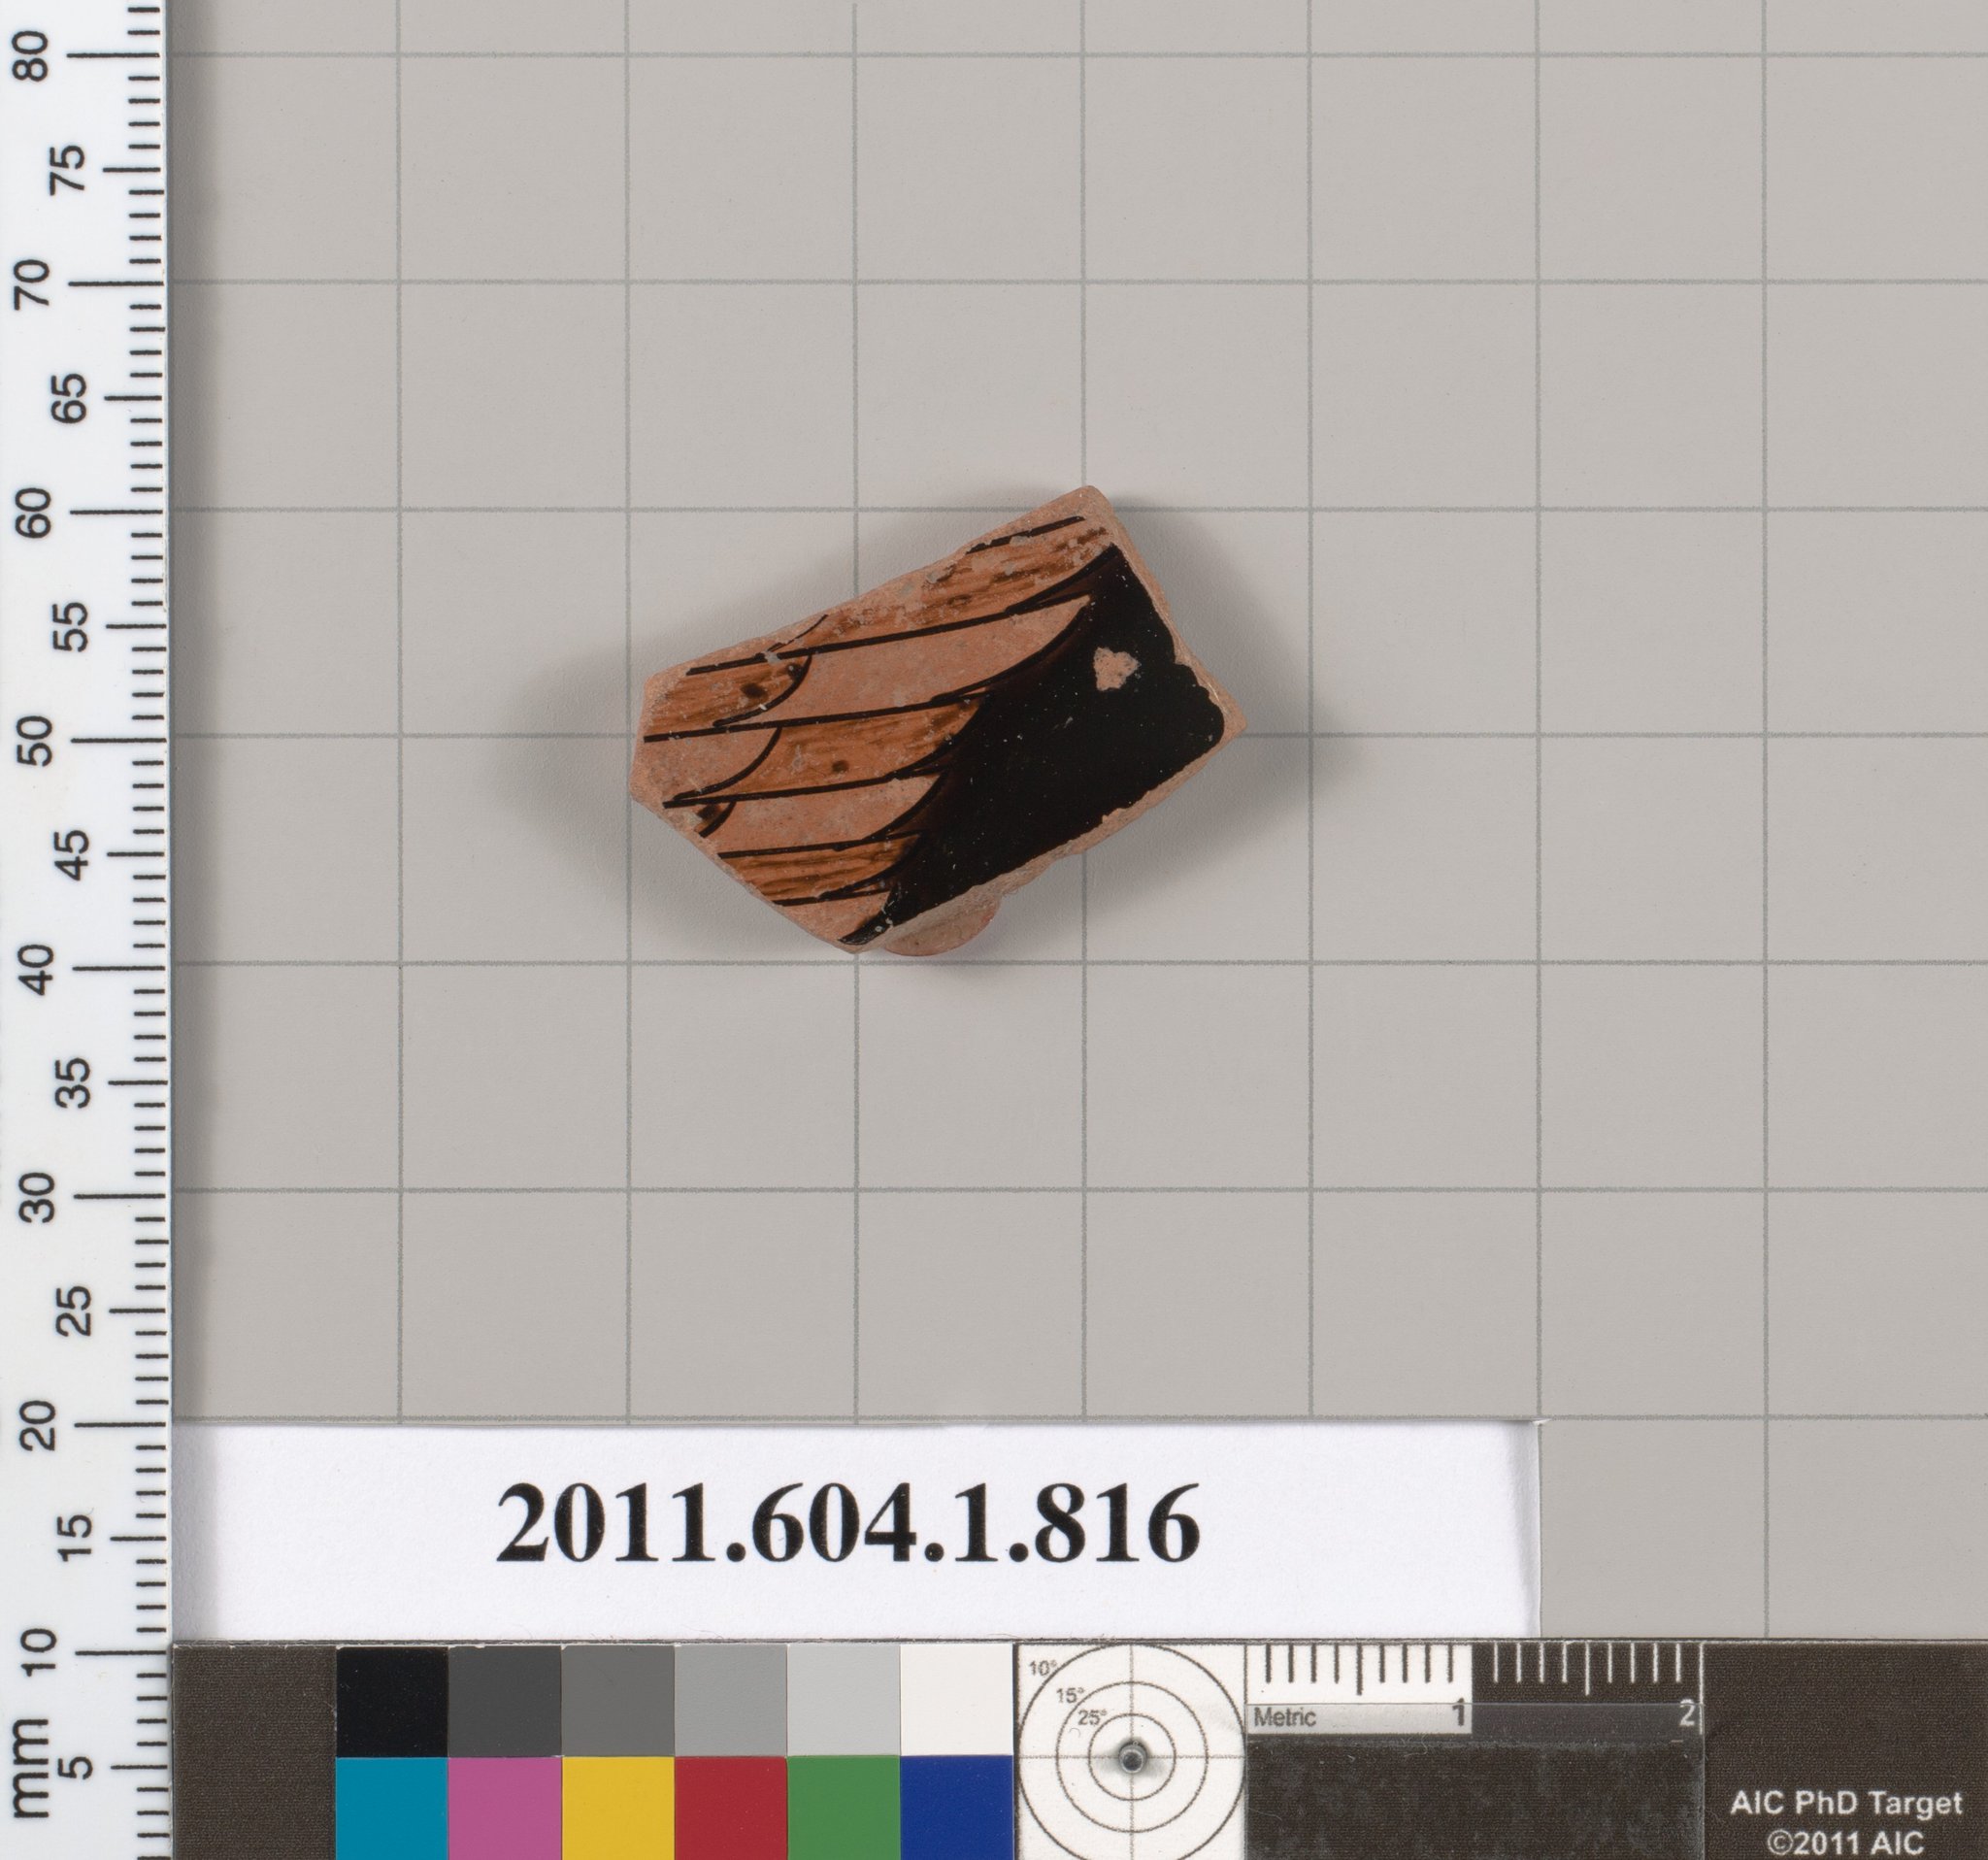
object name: kylix fragment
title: Terracotta fragment of a kylix (drinking cup)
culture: greek, attic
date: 490-480 BCE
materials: terracotta